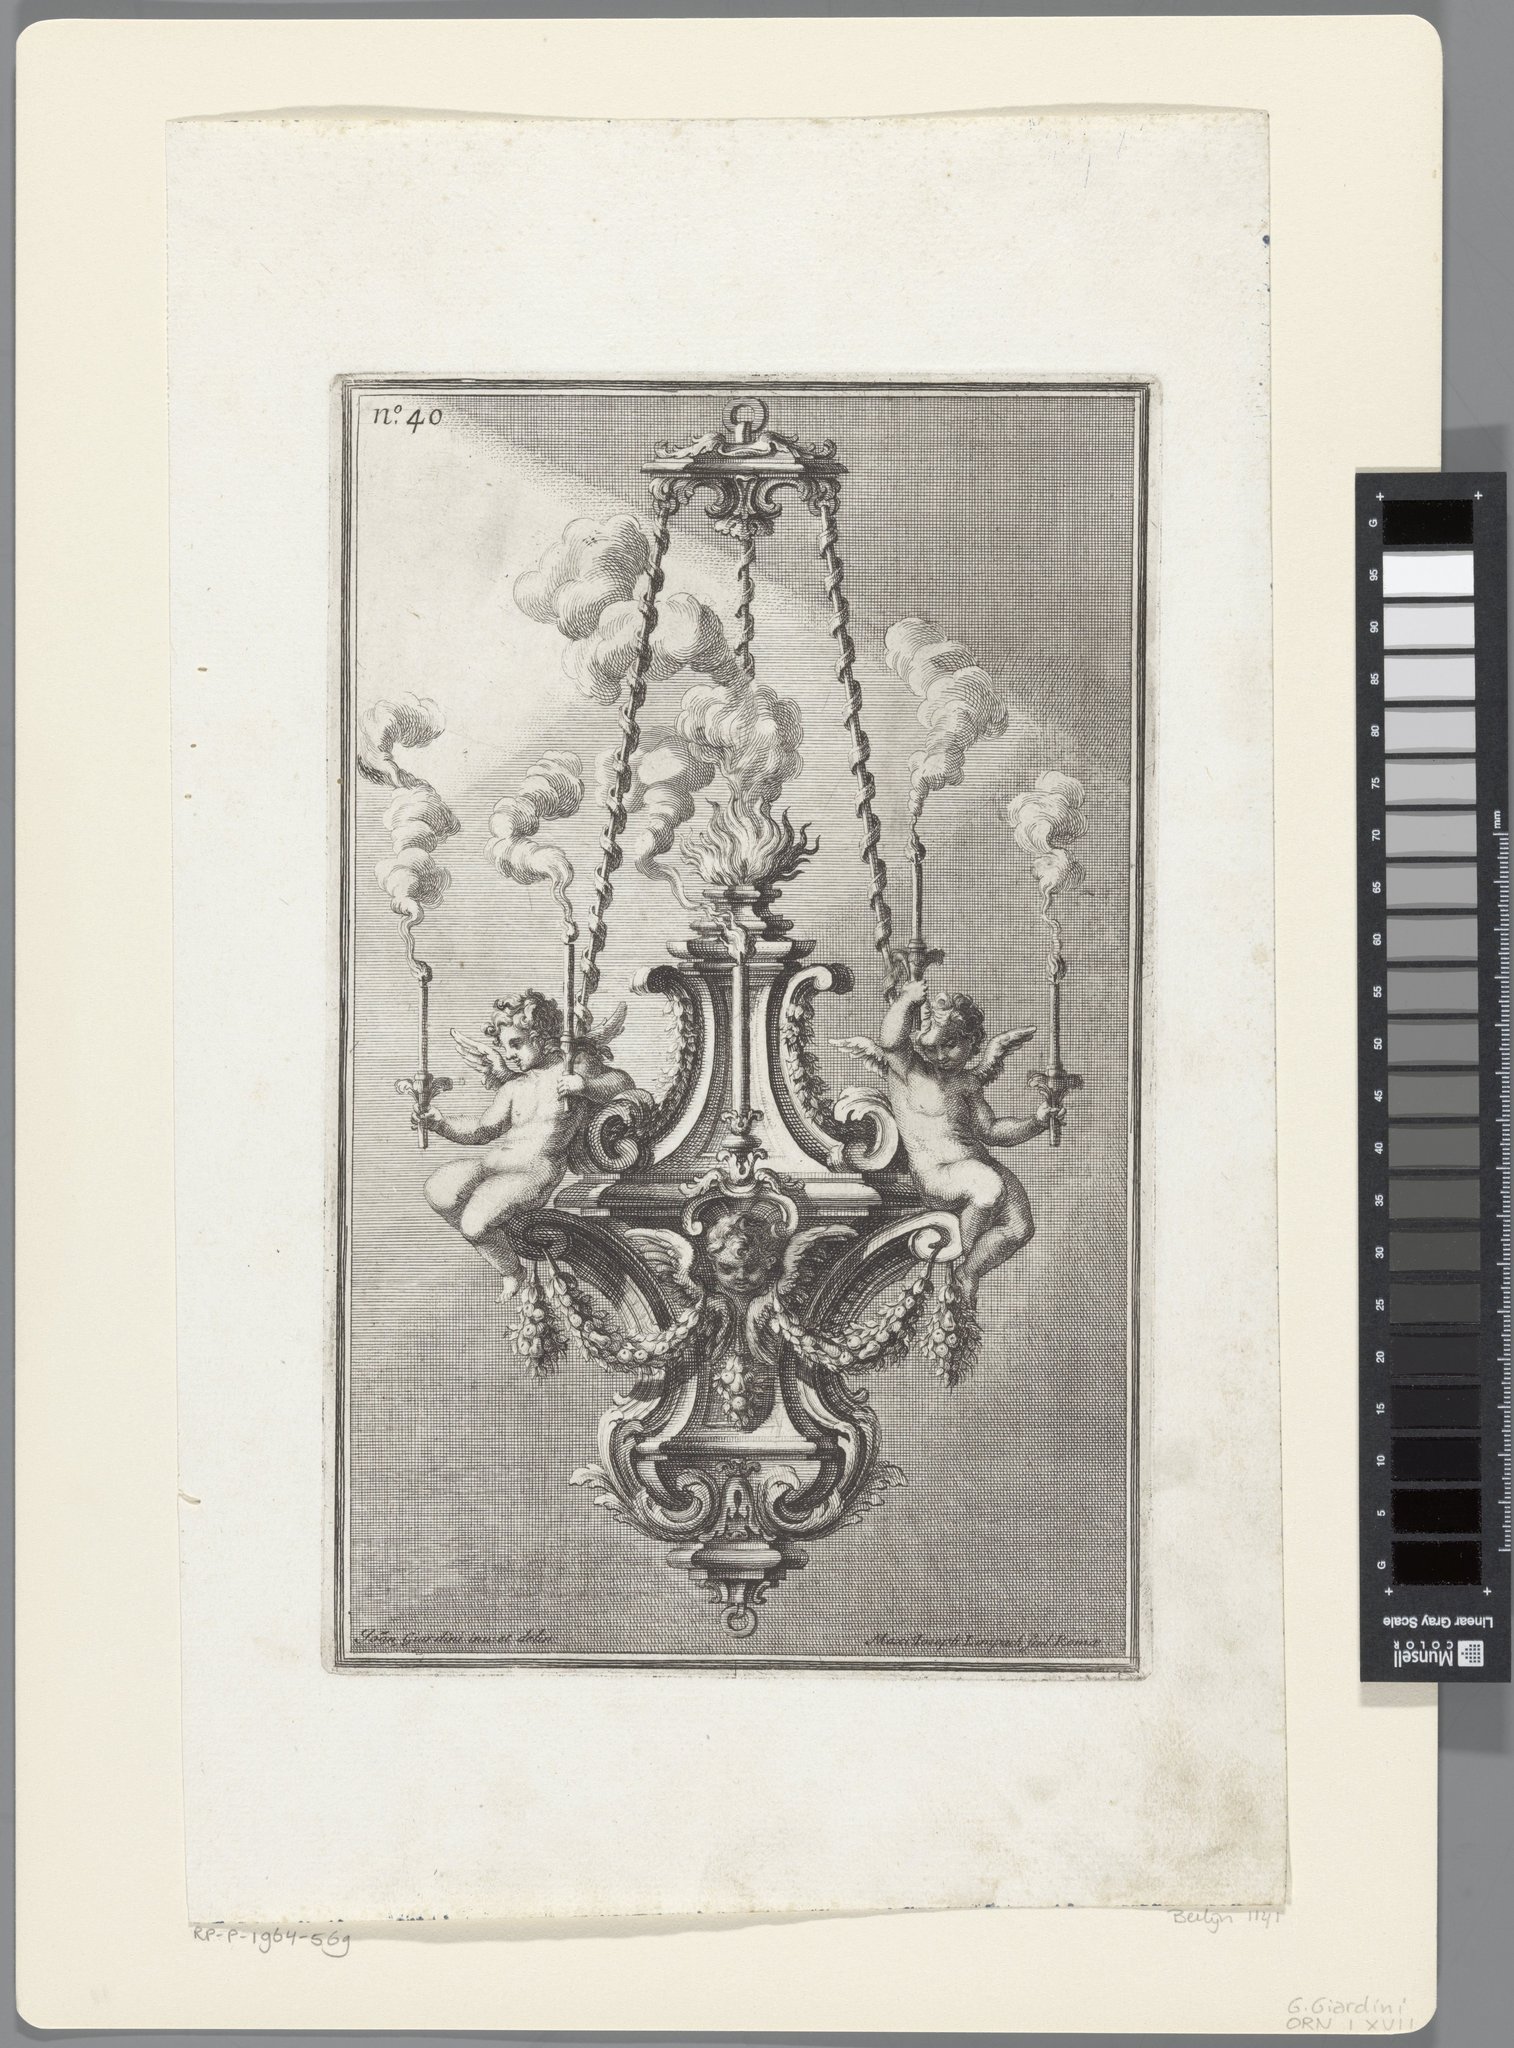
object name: print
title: Kroonluchter met twee putti en een pauselijk wapen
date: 1714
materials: paper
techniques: etching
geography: italy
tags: chandelier, candelabrum, cupids: 'amores', 'amoretti', 'putti'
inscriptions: collector's mark: Lugt 2228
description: Prent maakt deel uit van een reeks van 100 ornamentprenten naar ontwerp van Giovanni Giardini.